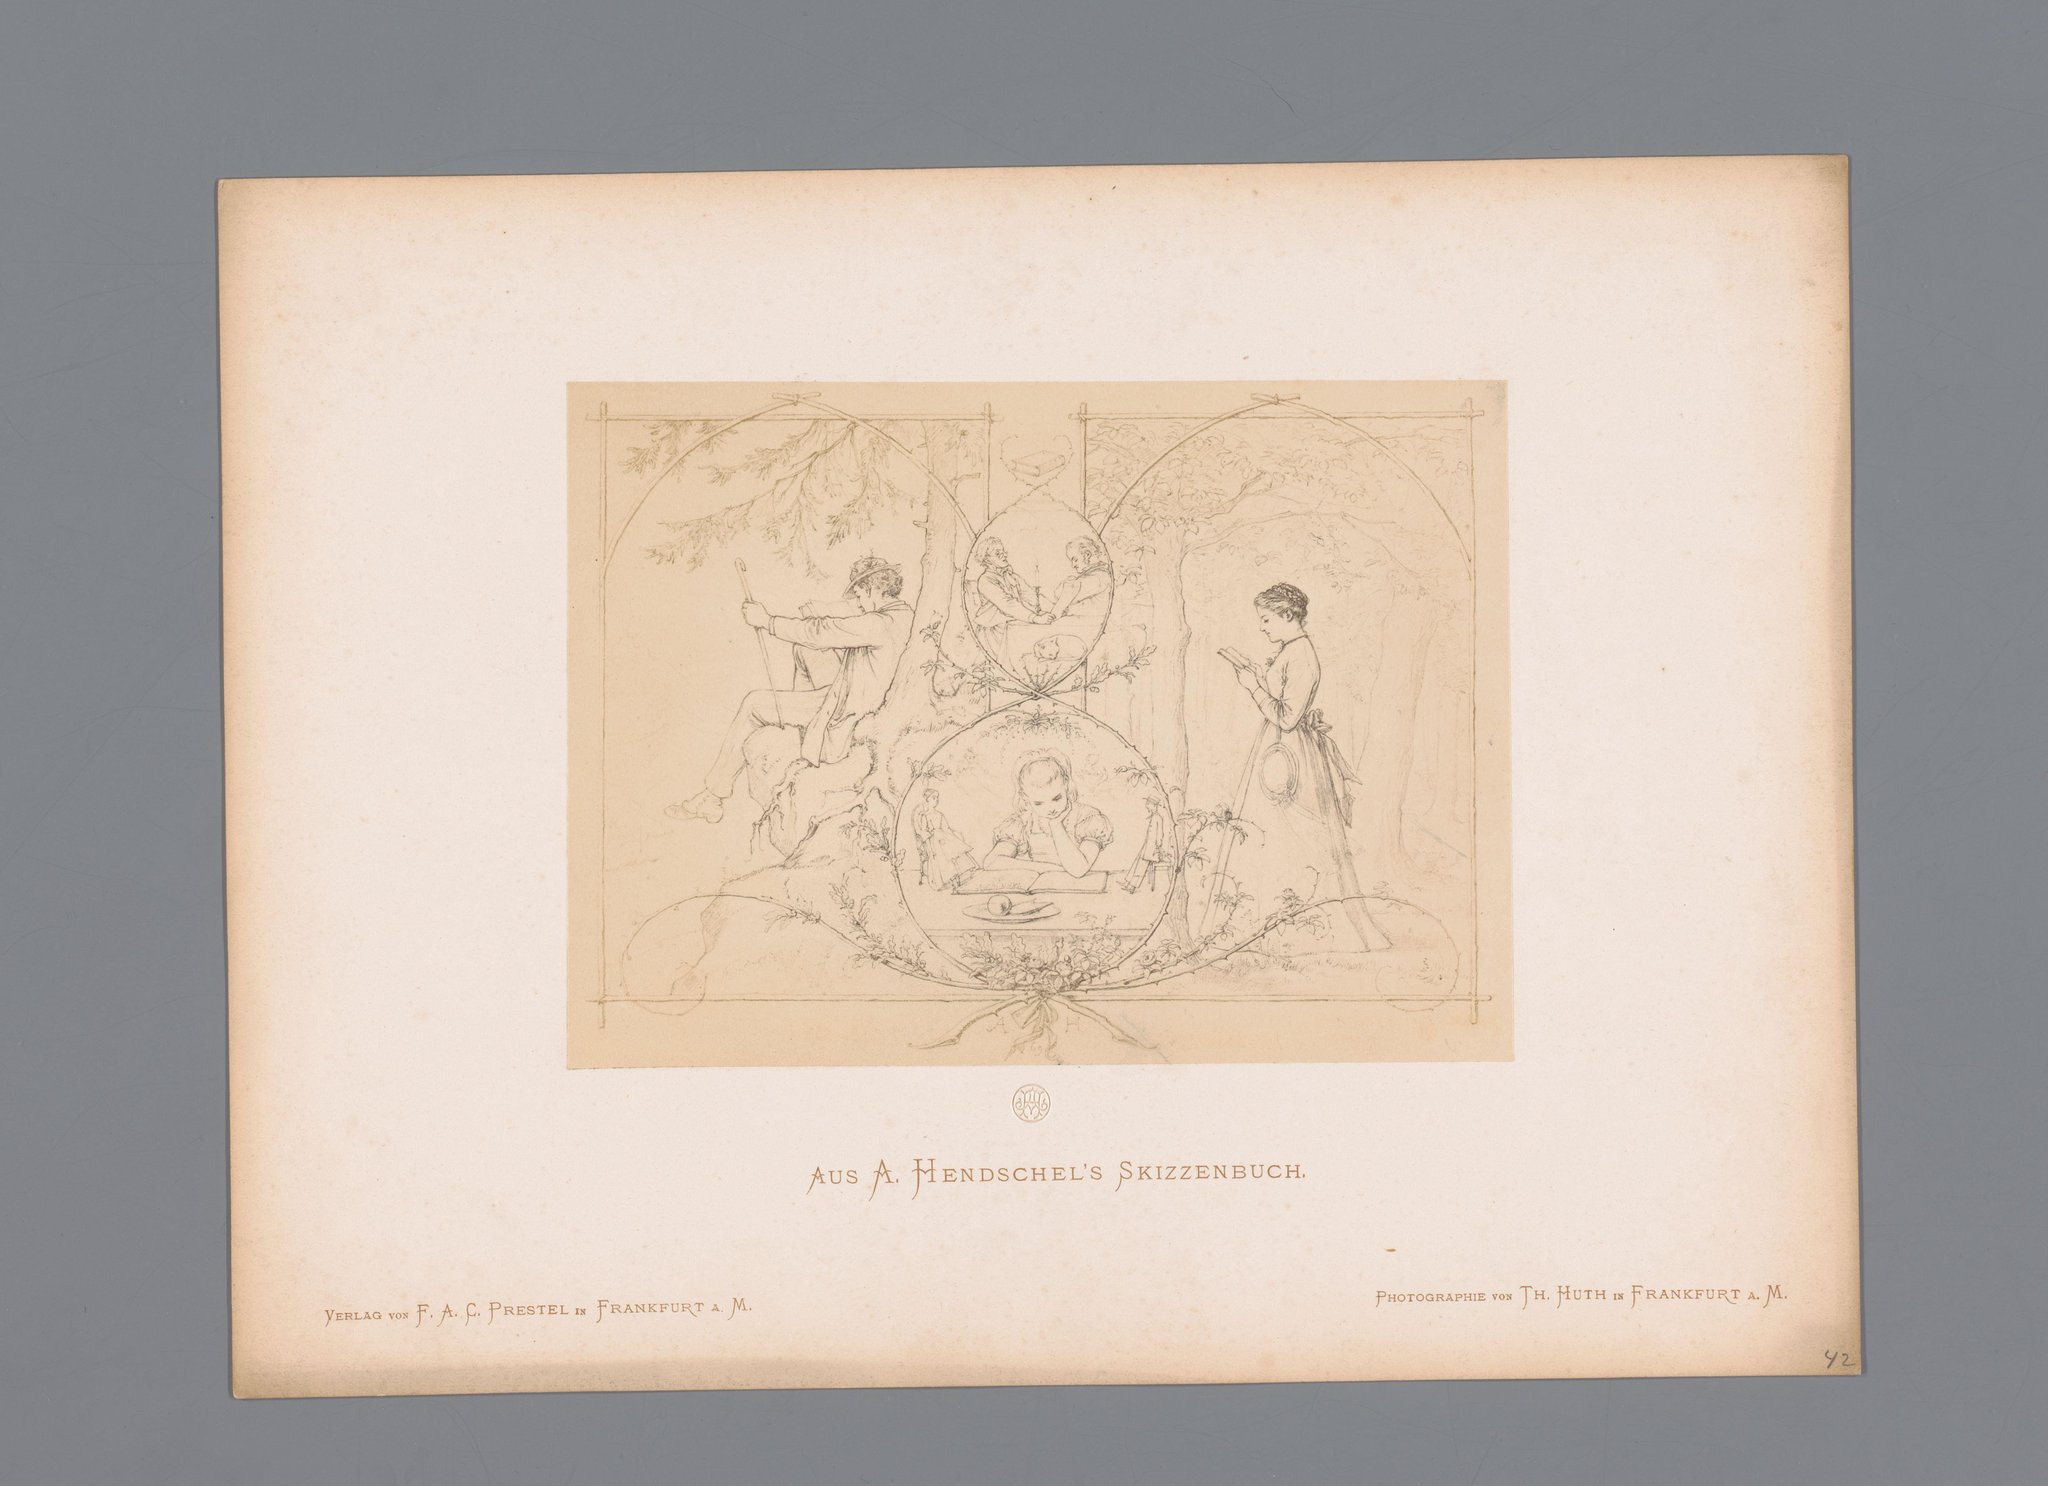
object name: reproduction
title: Aus A. Hendschel's Skizzenbuch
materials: photographic support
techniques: albumen print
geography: frankfurt am main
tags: adult woman, reading, adult man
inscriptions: number: ‘42’, monogram: ‘AH’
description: Deze foto maakt deel uit van een omslag met 50 foto's op 48 bladen, een lijst van afbeeldingen en een titelblad.